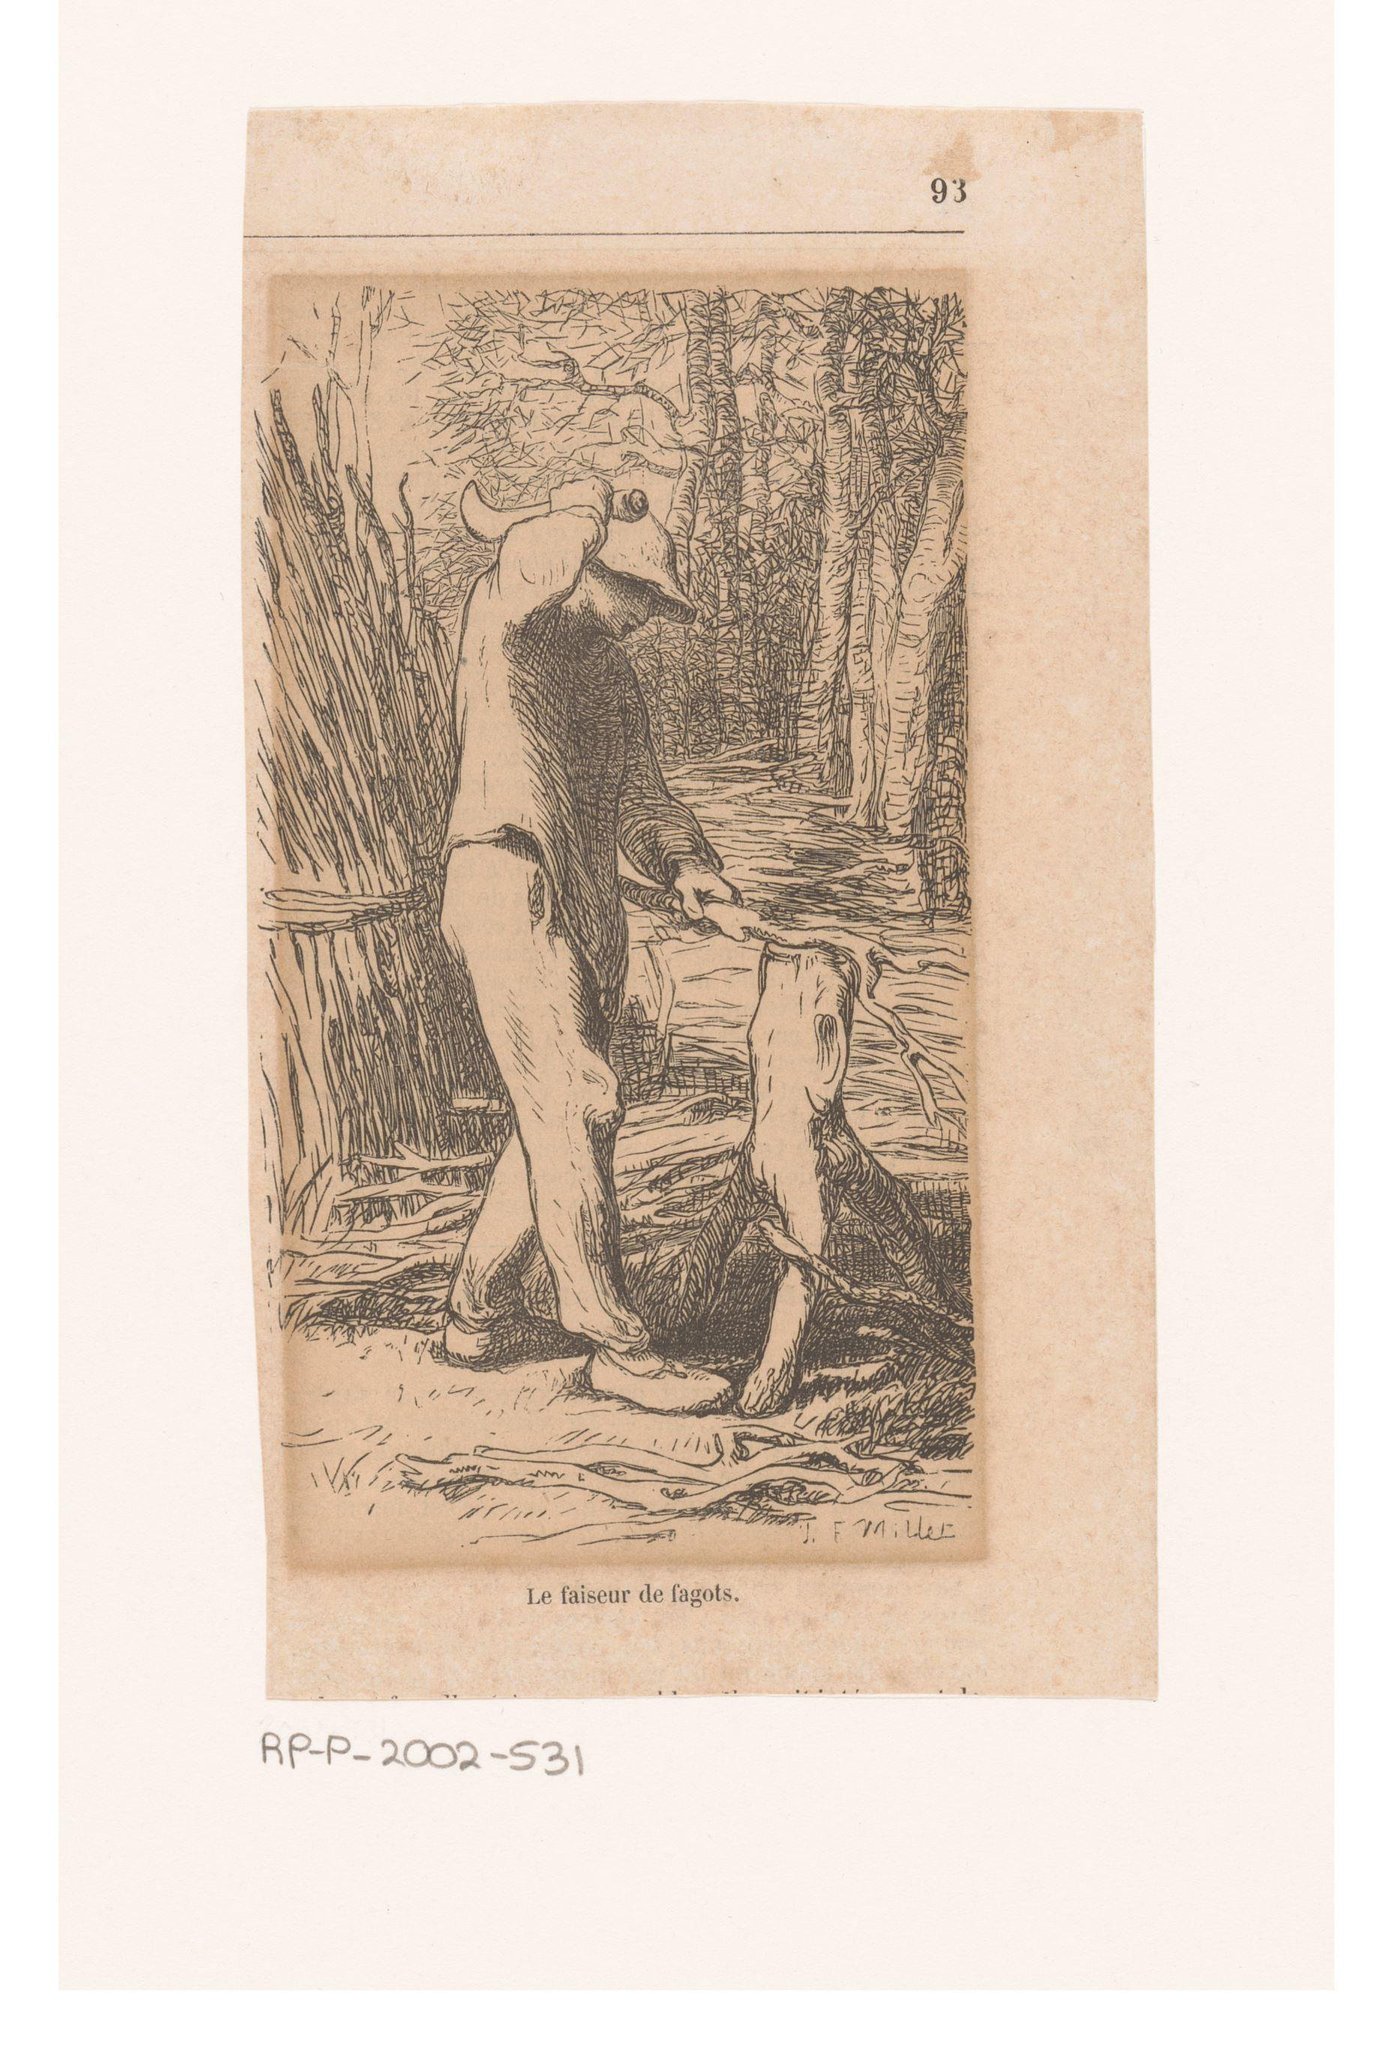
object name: print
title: Le faiseur de fagots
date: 1853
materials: paper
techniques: letterpress printing, engraving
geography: paris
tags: crafts and industries (+ agricultural processes), woodcutting, woodcutter ~ forestry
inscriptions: collector's mark: Lugt 2228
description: Prent maakt deel uit van een serie van tien houtgravures gepubliceerd in 'L'Illustration' van 5 februari 1853, bij het artikel Revue Agricole van Saint-Germain Leduc.